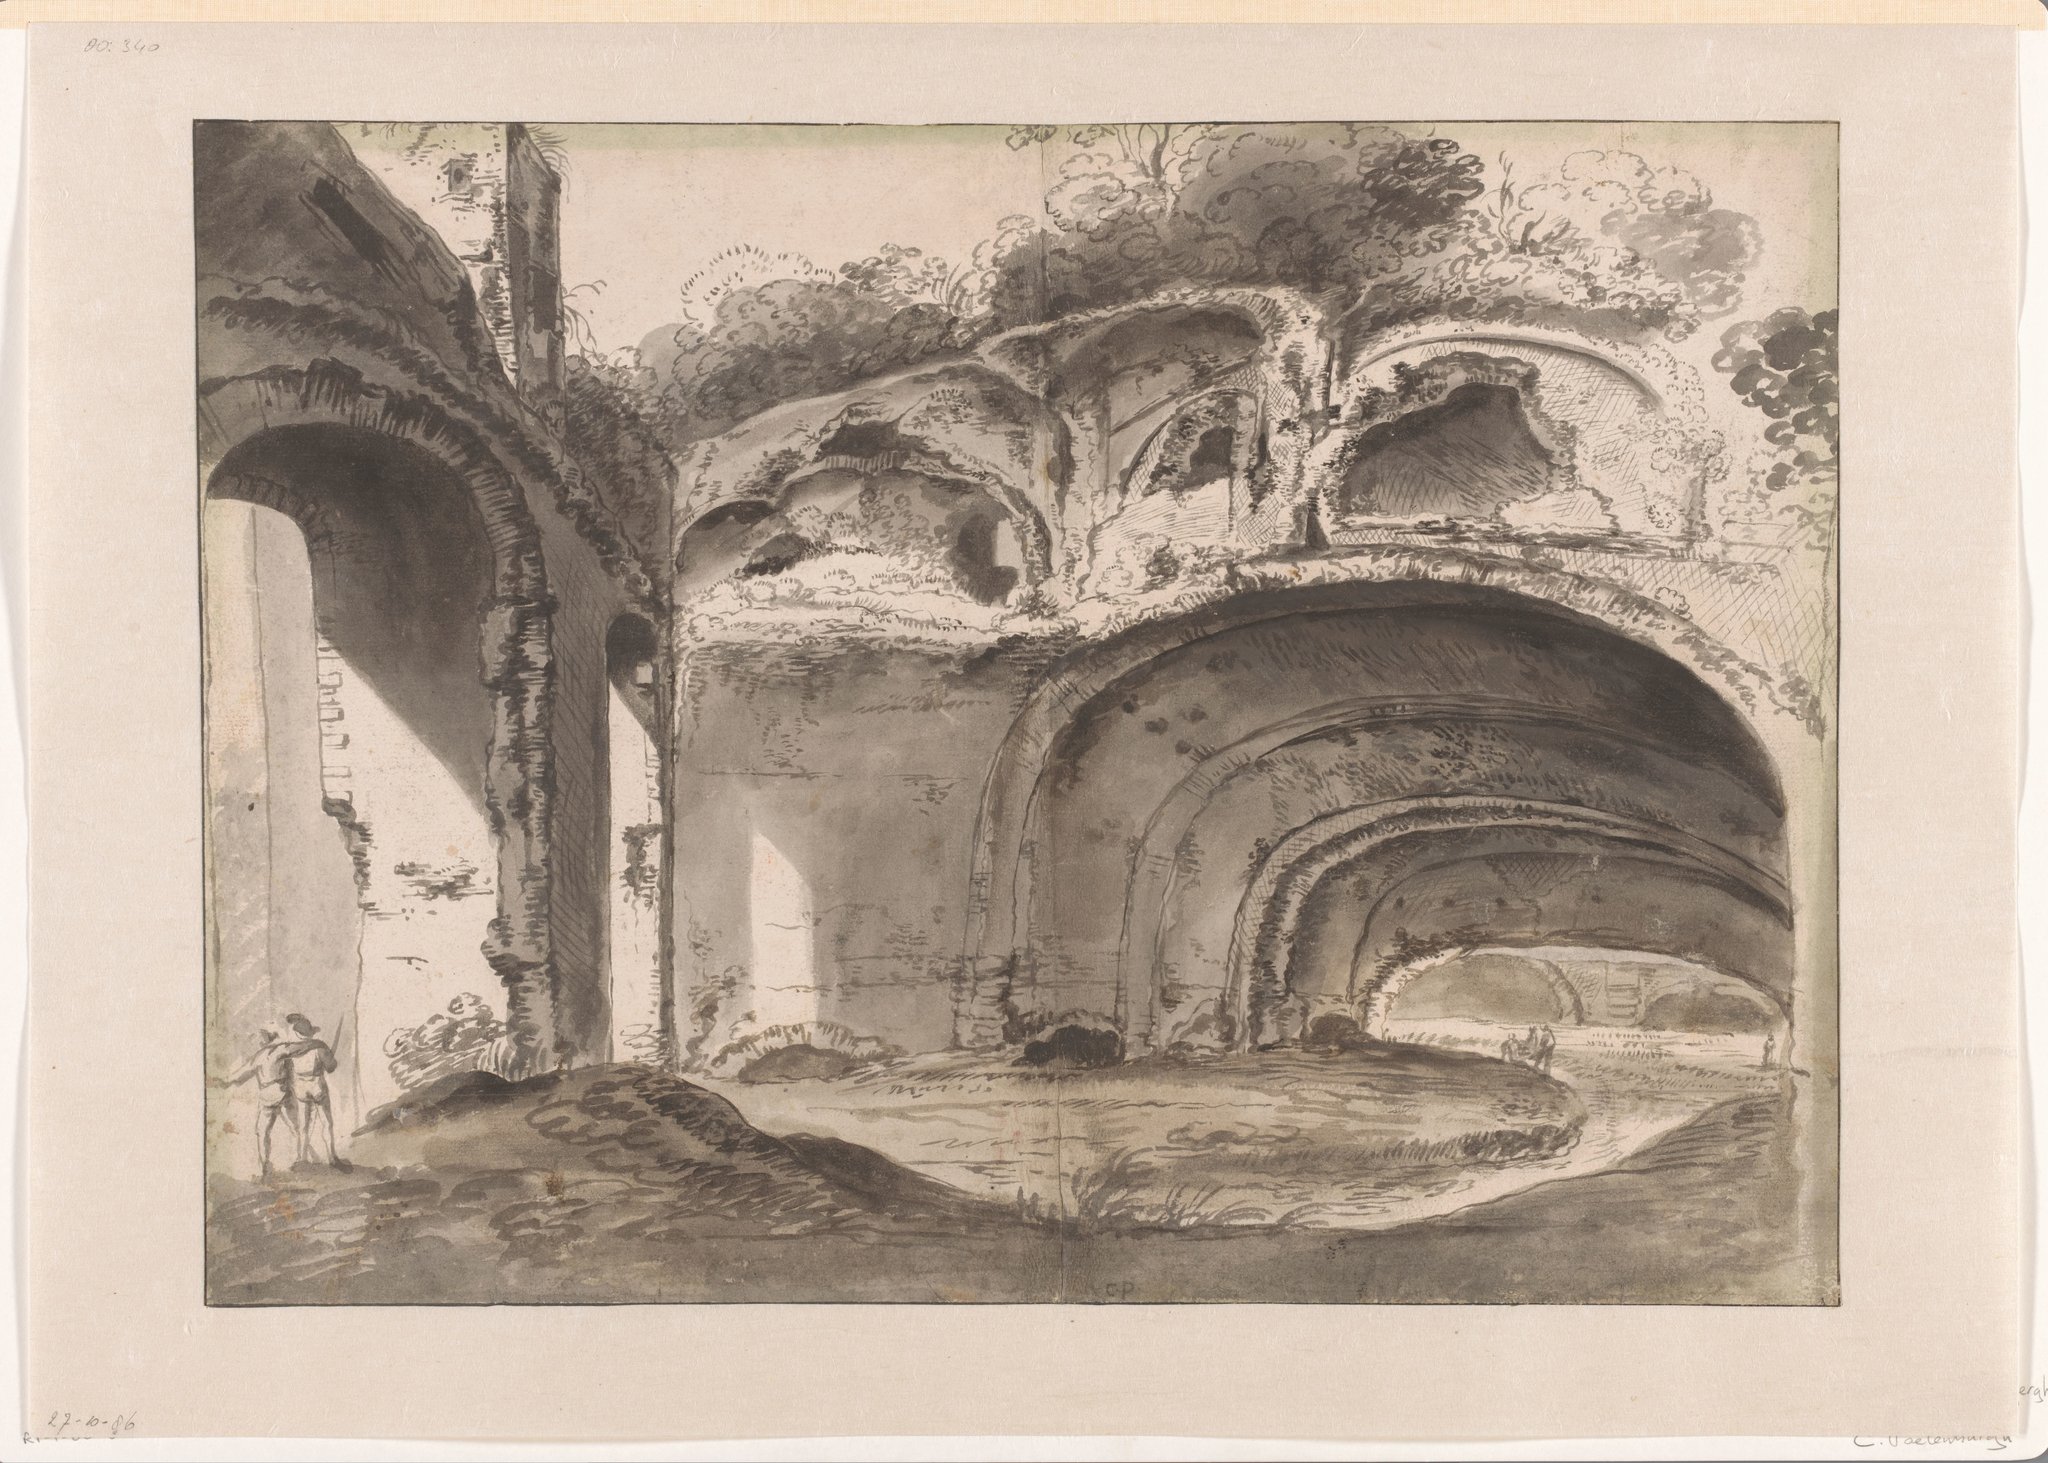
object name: drawing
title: Ruïne van de Villa van Maecenas te Tivoli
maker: cornelis van poelenburch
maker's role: draughtsman, painter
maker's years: 1594-1667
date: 1600-1667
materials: paper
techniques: brush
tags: ruin of a building ~ architecture, vault ~ architecture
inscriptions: monogram: ‘C.P.’